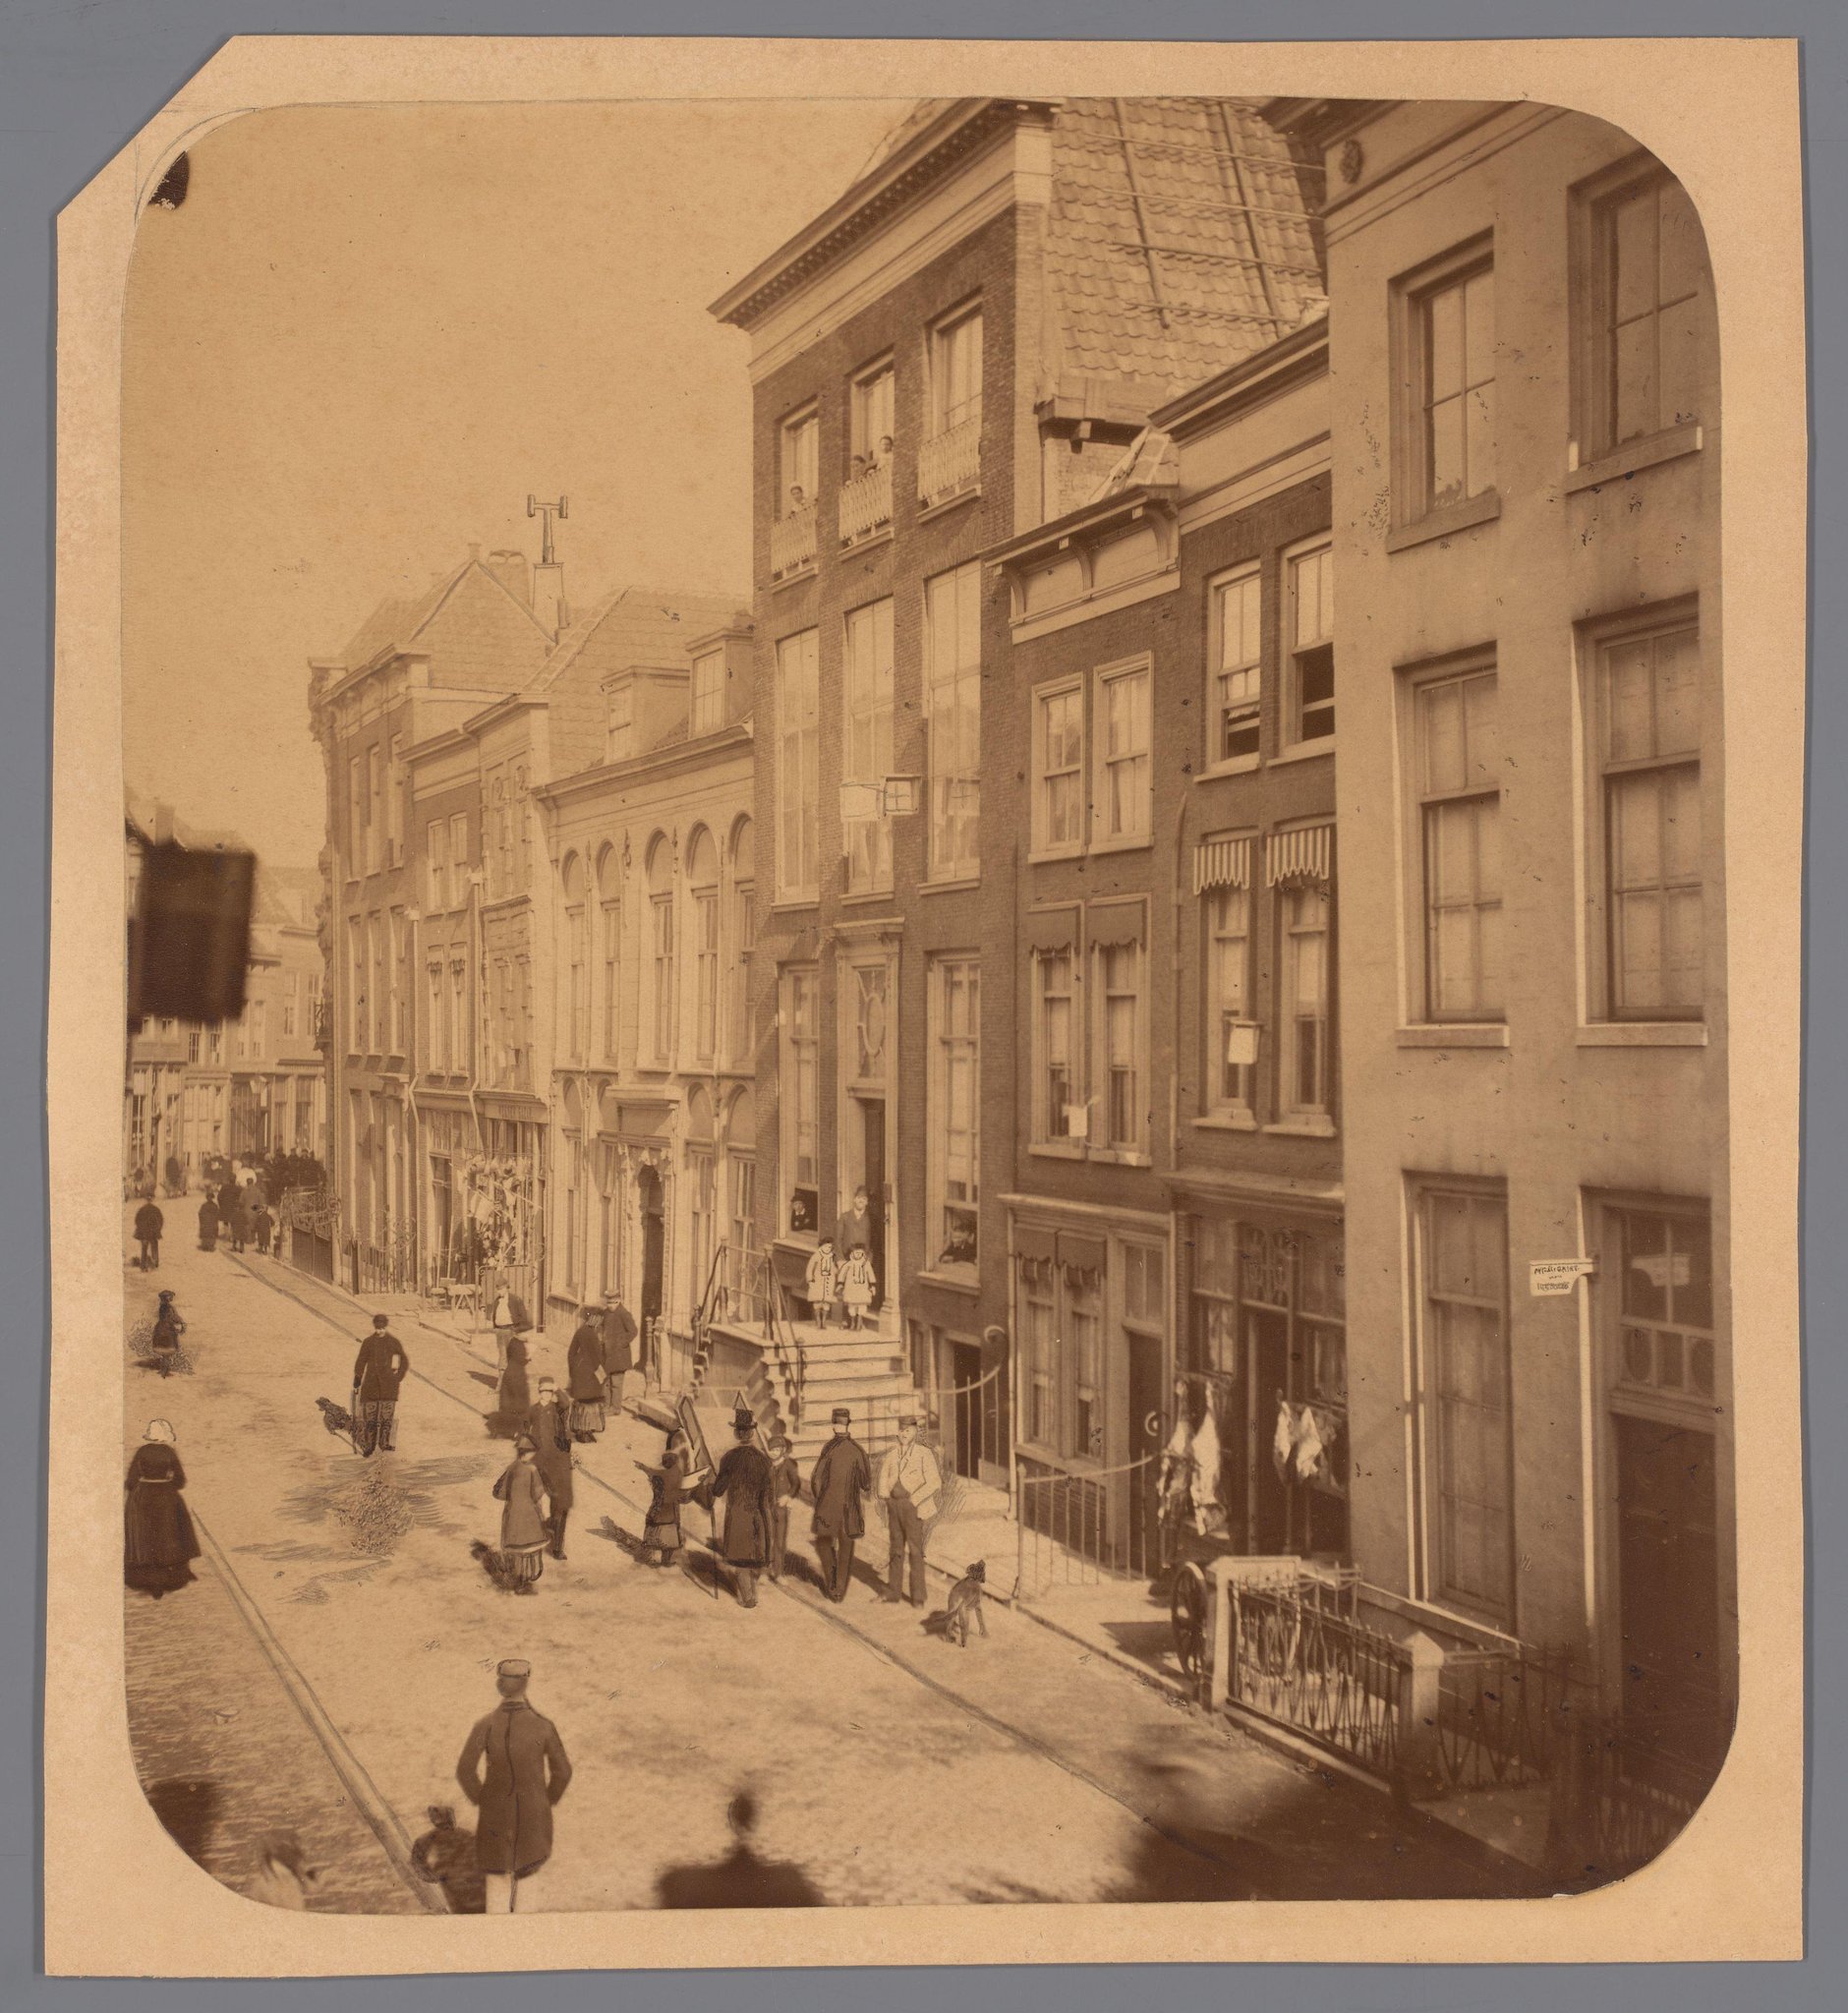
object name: photograph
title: Straattafereel, Nederland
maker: Anonymous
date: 1855-1875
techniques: albumen print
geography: netherlands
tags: street (+ city(-scape) with figures, staffage)